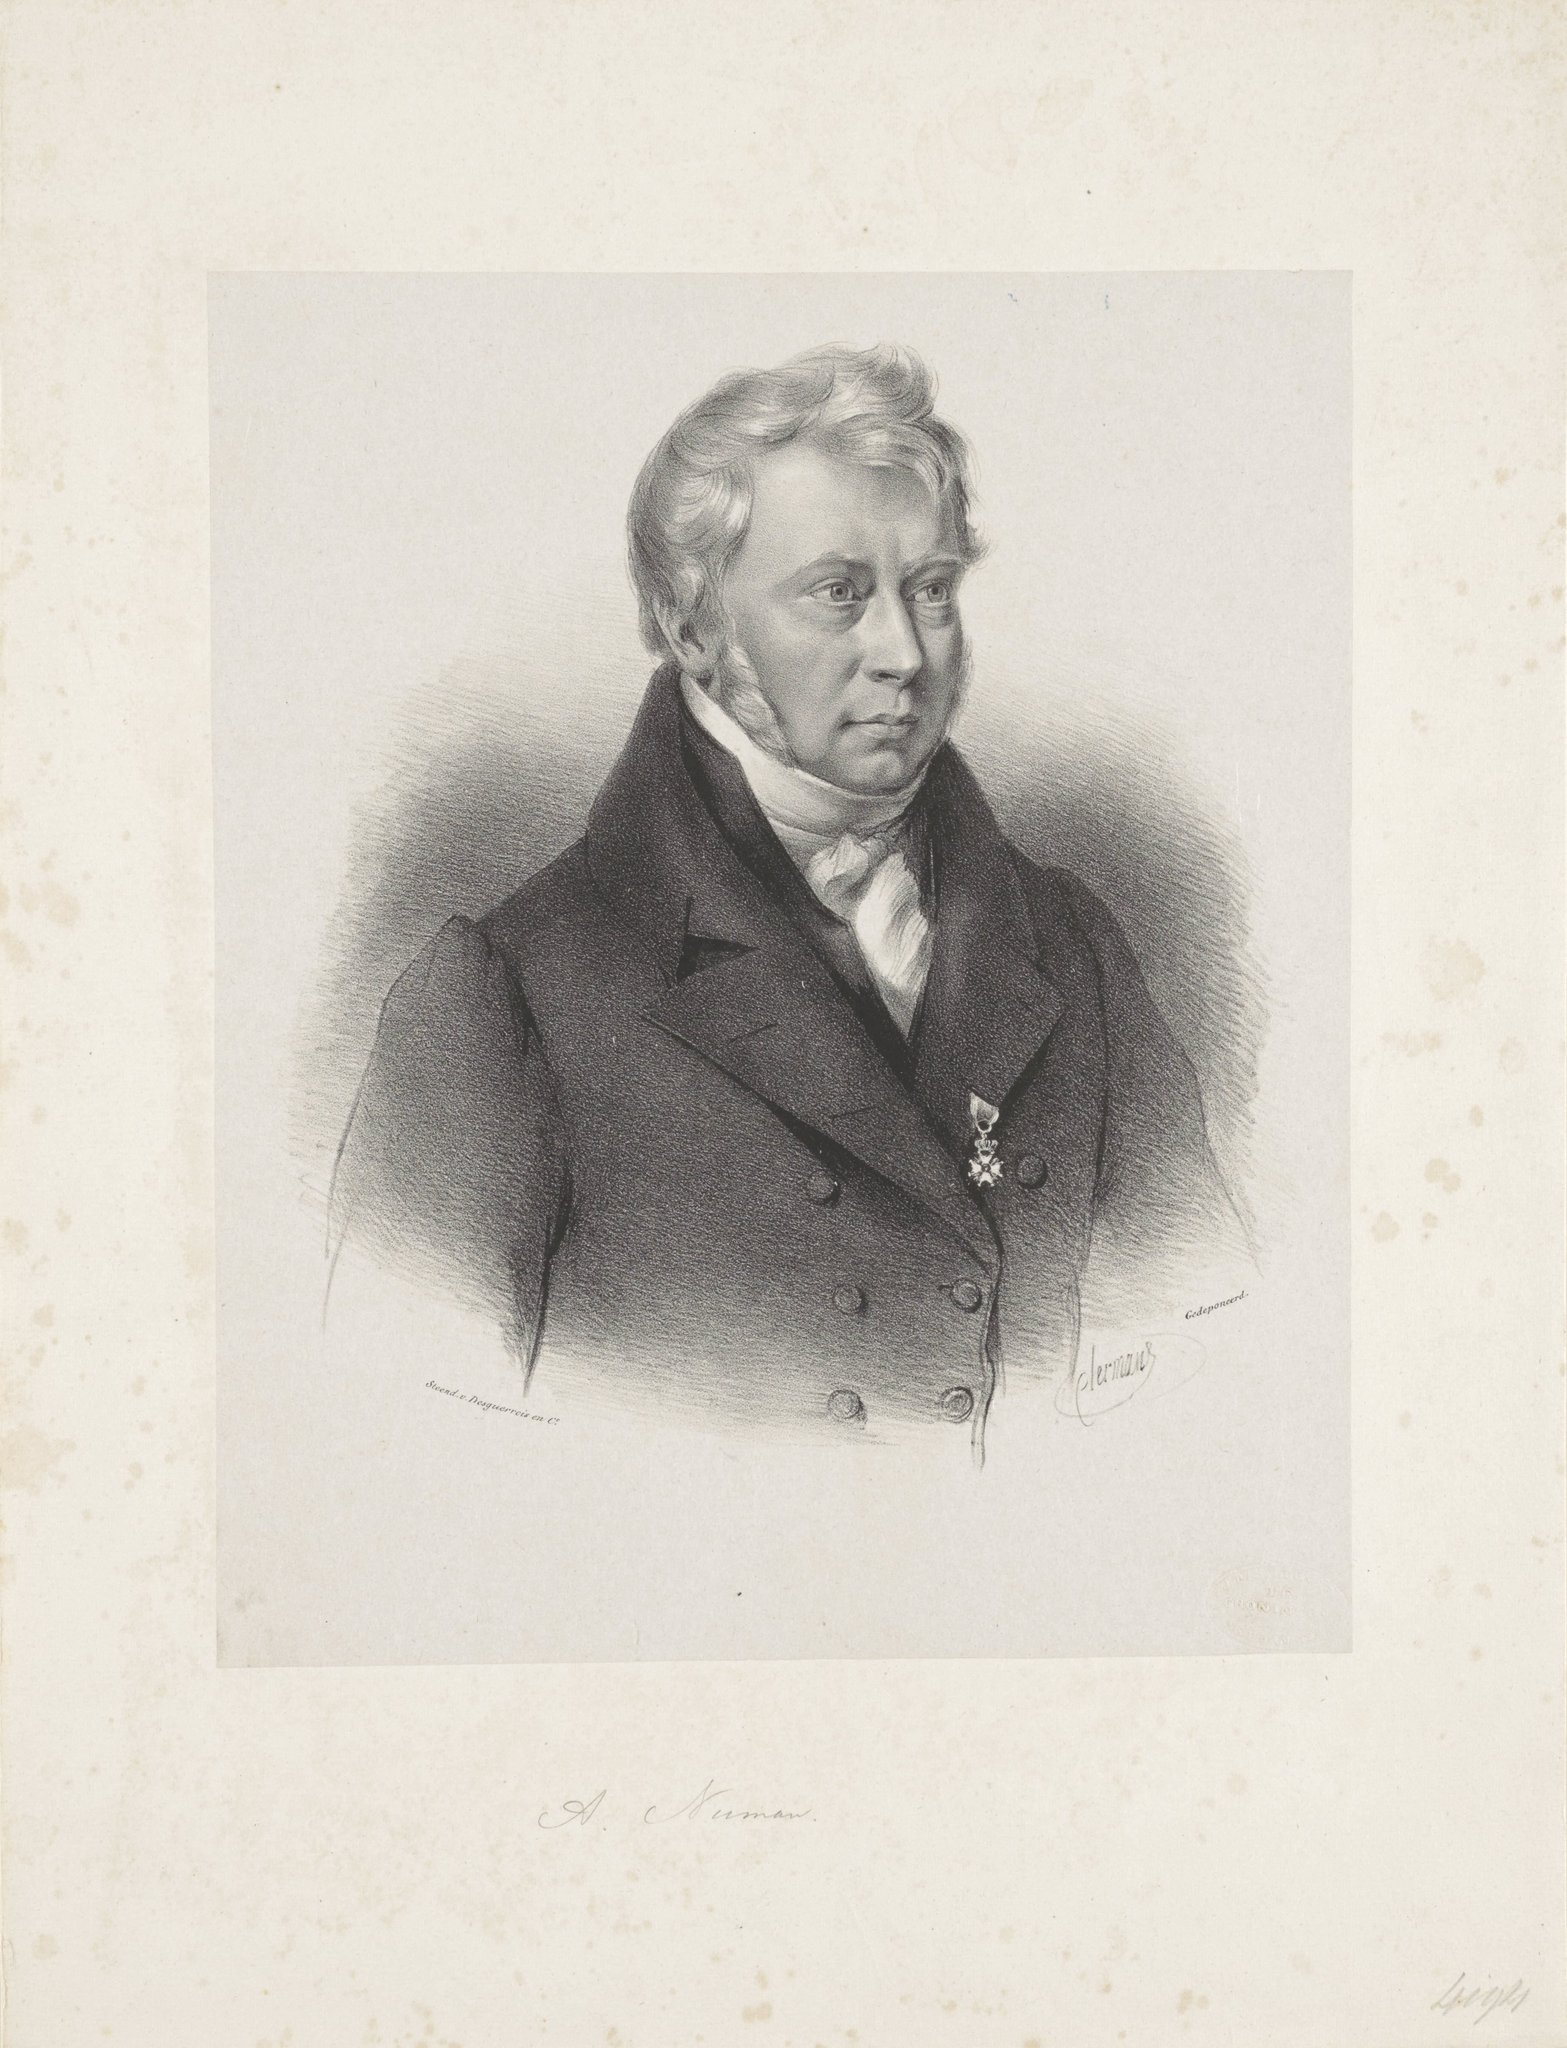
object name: print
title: Portret van Alexander Numan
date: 1826-1839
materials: paper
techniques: lithograph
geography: amsterdam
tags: utrecht, knighthood order, historical persons (+ (full) bust portrait)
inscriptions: collector's mark: Lugt 2228, : ‘Gedeponeerd.’, inscription: ‘A. Numan’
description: De geportretteerde kijkt naar rechts en draagt een ridderorde aan de revers van zijn jas.